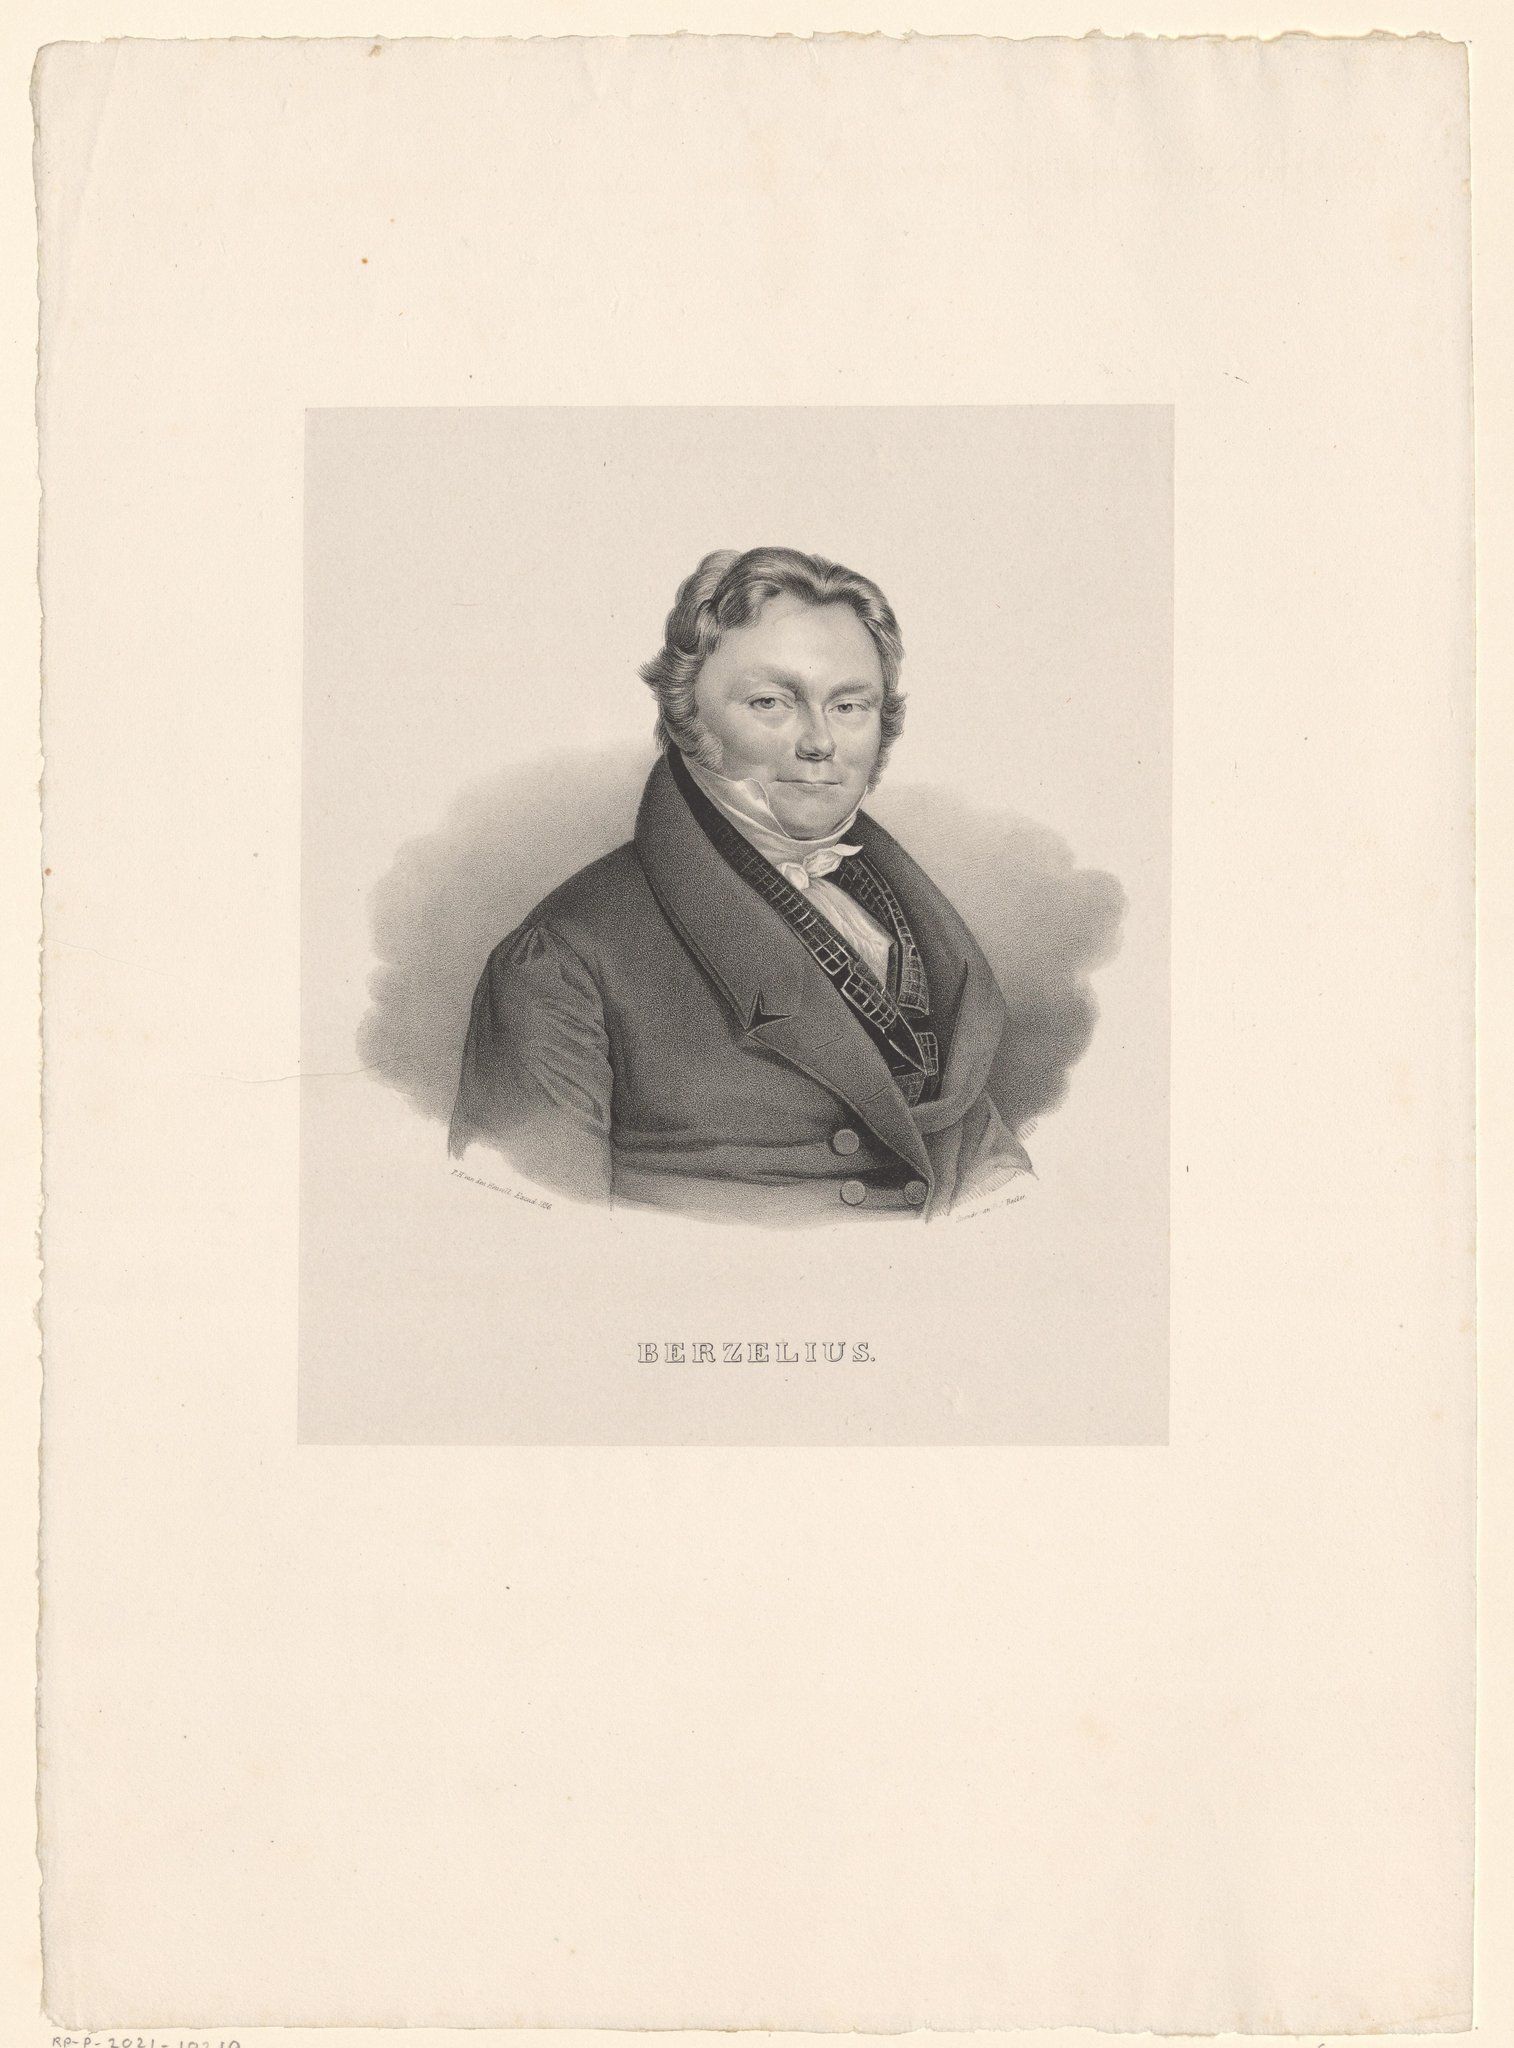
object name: print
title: Portret van Jöns Jacob Berzelius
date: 1836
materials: paper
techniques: lithograph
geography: dordrecht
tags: chemistry (+ portrait of scholar, scientist), historical persons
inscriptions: collector's mark: Lugt 2228